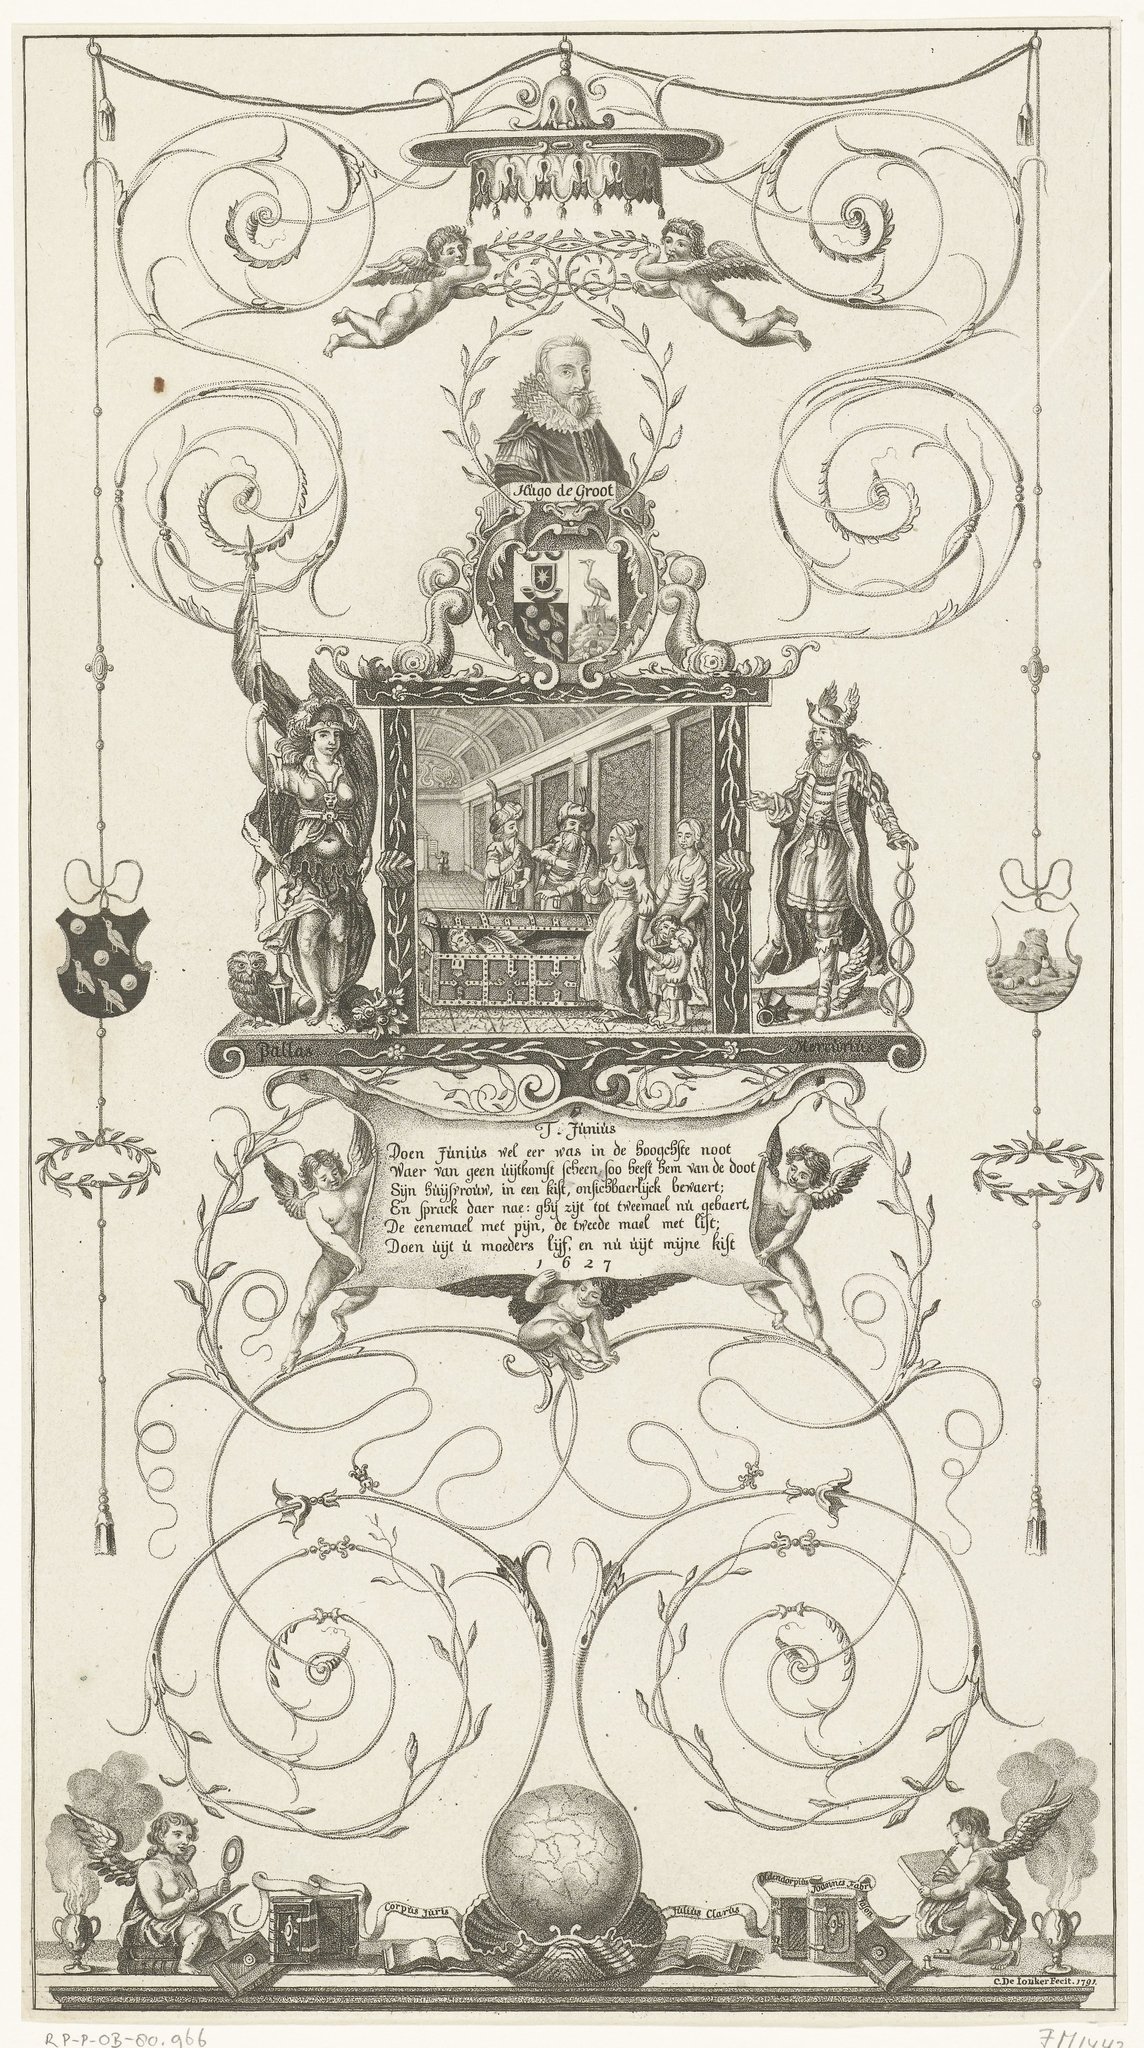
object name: historical object representation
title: Glasruit met scène uit het historie van Titus Junius, met buste van Hugo de Groot, 1627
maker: cornelis de jonker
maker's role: draughtsman, print maker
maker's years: 1761-1830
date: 1791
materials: paper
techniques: etching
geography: netherlands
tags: delft, hugo de groot, art (+ making stained glass), window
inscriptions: date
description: Glasruit met scène uit het historie van Titus Junius, bekroond met een buste van Hugo de Groot, 1627. Titus Junius verschuilt zich in een kist. Aan weerszijden Pallas en Mercurius, verder versierd met ranken, wapens en putti. Onder de centrale scène een vers van 6 regels. Onderdeel van een serie van drie allegorische glasruiten ter herinnering aan de gevangenschap, vlucht en ballingschap van Hugo de Groot, 1619-1622. In 1627 vervaardigd voor het huis van Abraham Daatselaar, de koopman te Gorcum die Hugo de Groot heeft helpen ontvluchten.